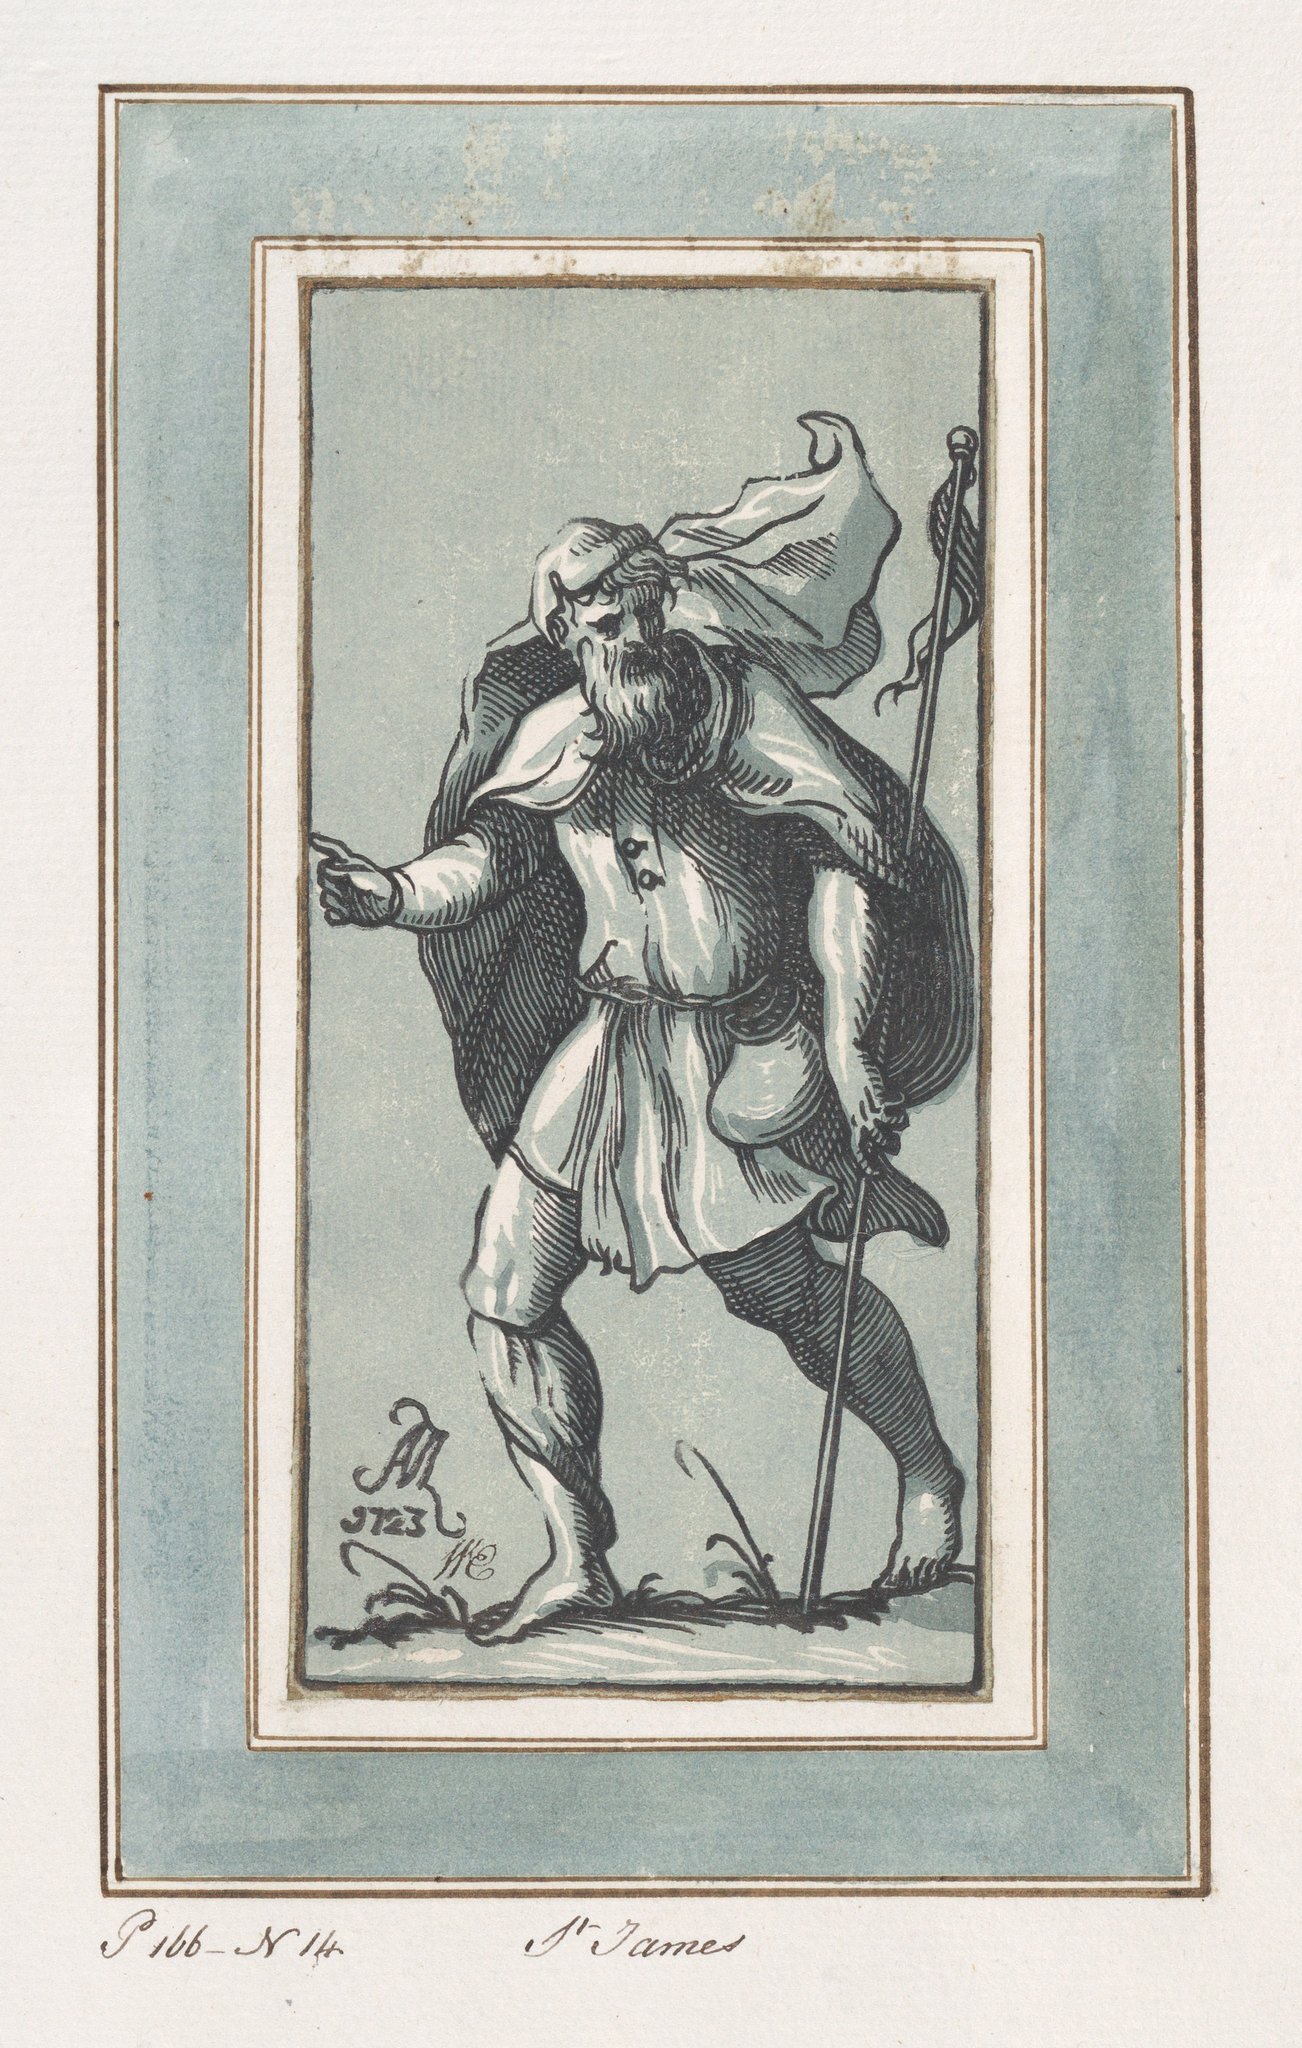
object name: print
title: Saint James the Greater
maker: conte anton maria zanetti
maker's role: artist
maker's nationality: italian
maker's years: 1680-1767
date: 1723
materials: gold, watercolor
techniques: woodcut, printing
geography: venice